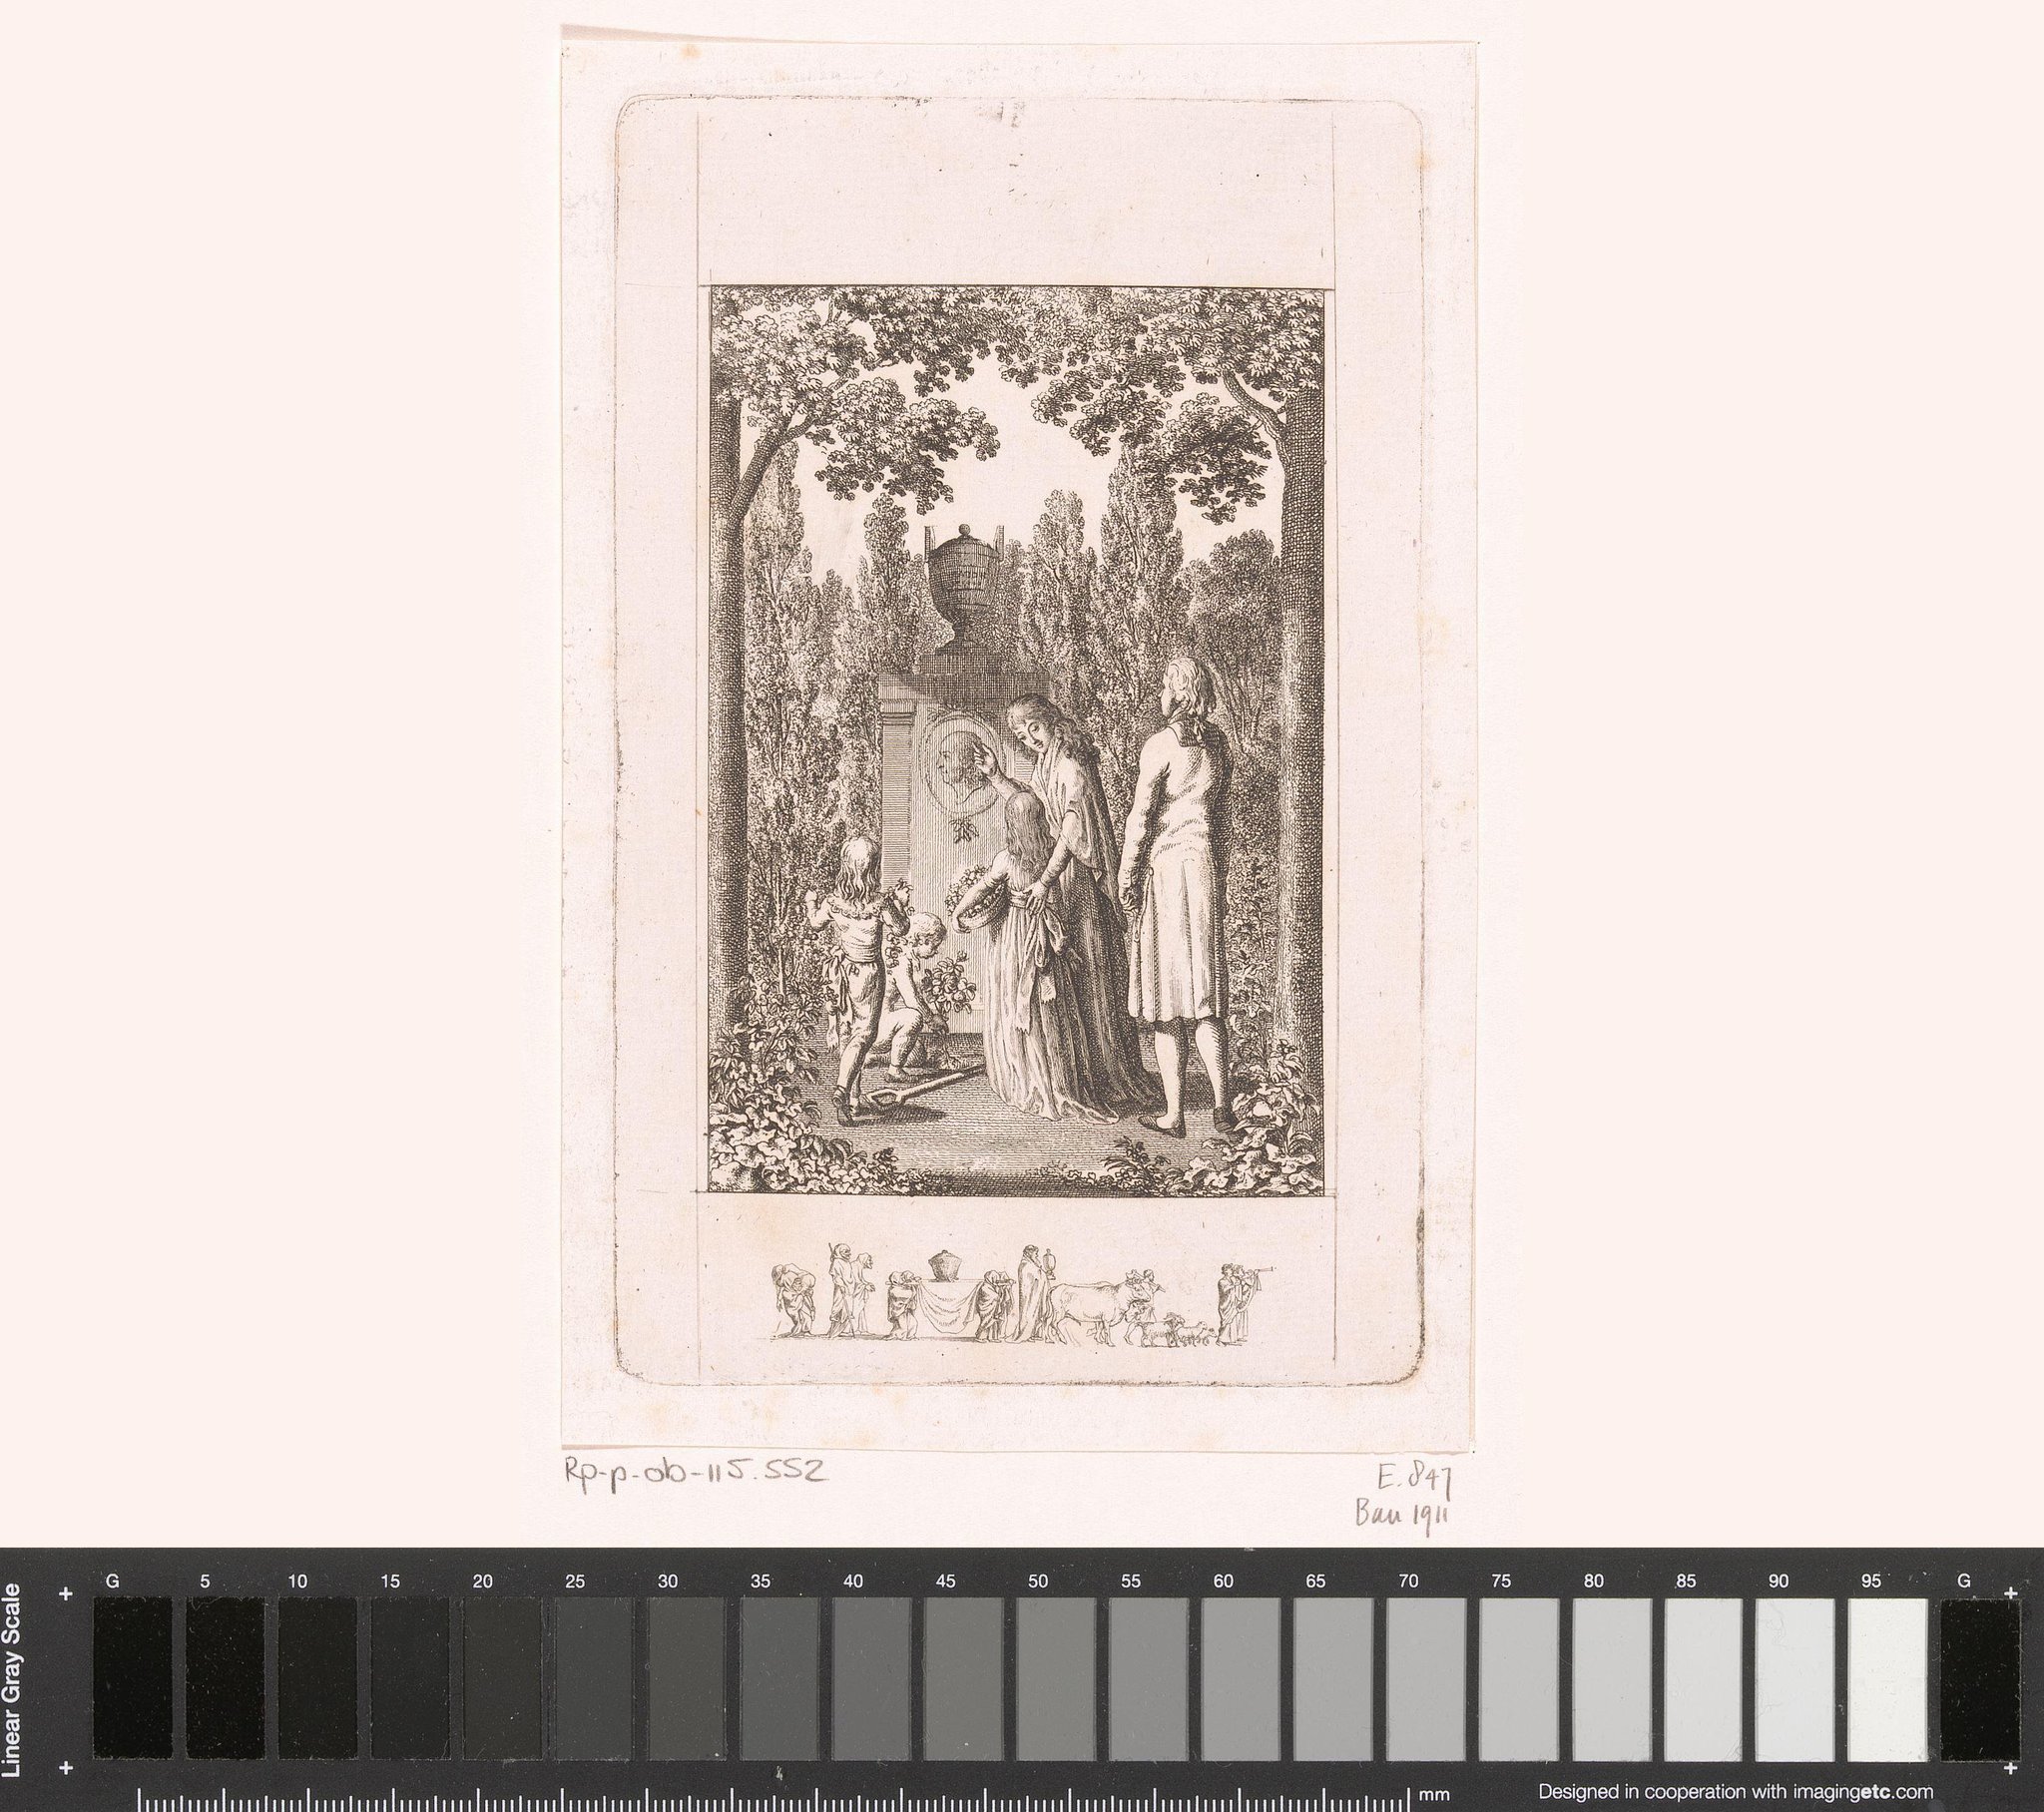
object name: print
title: Kinderen leggen bloemen bij het graf van hun grootvader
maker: daniel nikolaus chodowiecki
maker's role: draughtsman, print maker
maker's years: 1726-1801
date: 1797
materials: paper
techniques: etching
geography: berlin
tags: laying flowers or wreath on grave, grave, tomb, family, descendance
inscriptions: collector's mark: Lugt 2228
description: Prent gebruikt voor: Lang, Karl. Almanach und Taschenbuch für Häusliche und Gesellschaftl. Freuden (...). Heilbronn: Industrie Comtoir, s.a.